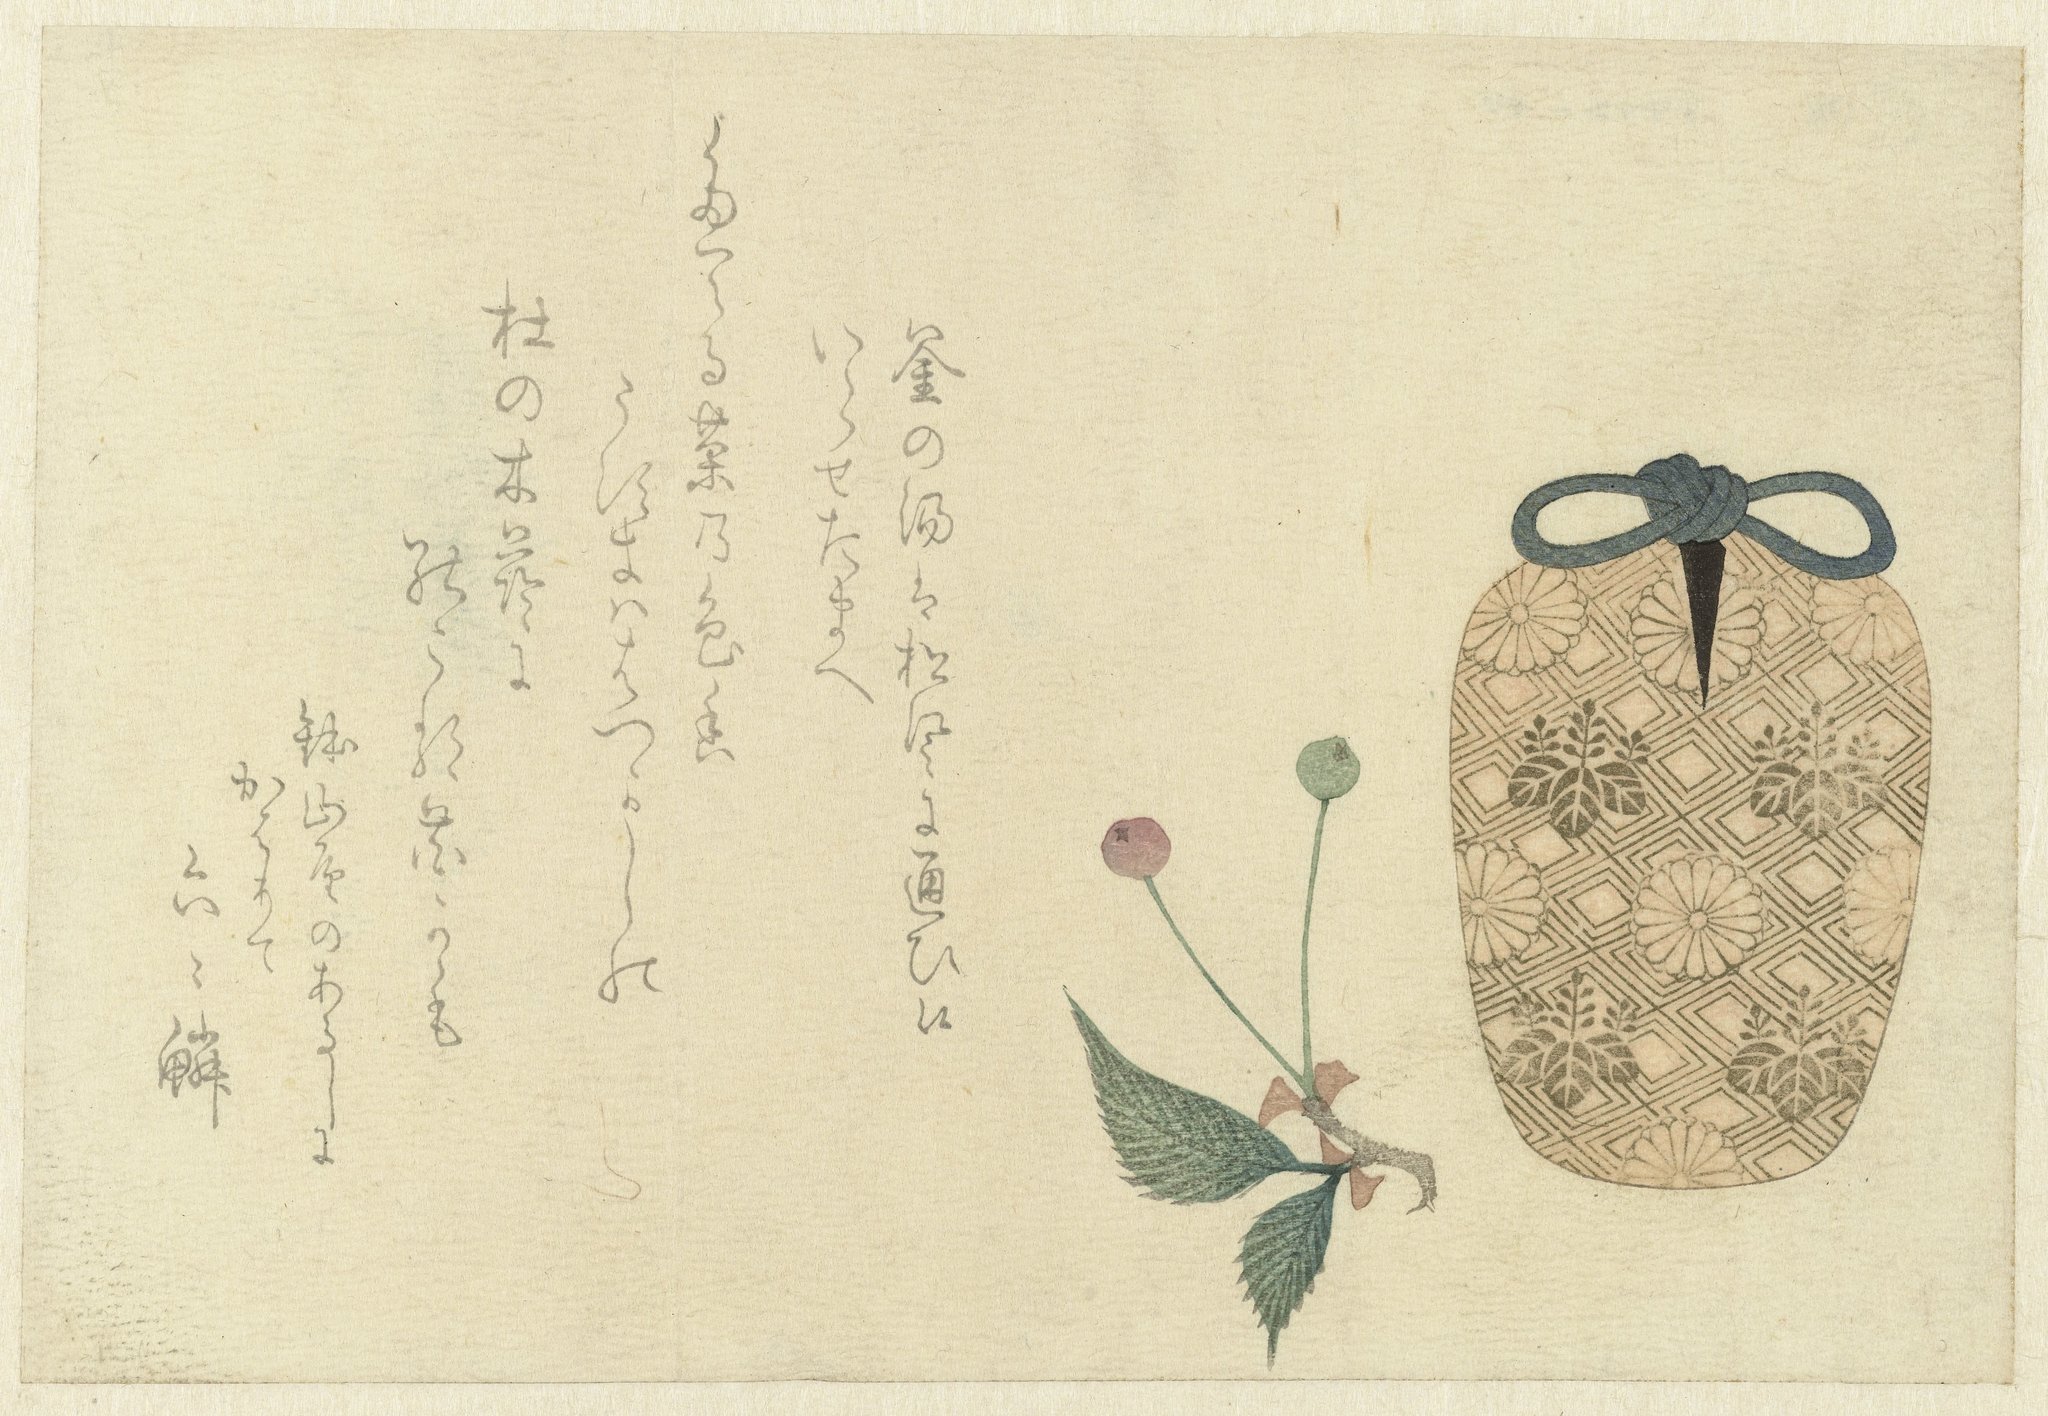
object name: print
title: Cherries and Tea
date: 1820-1830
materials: paper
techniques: woodcut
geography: japan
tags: tea-pot; samovar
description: In this surimono it is clear to see that text and image form a single entity. The various components ensure that the composition is beautifully balanced. An undulating movement starts with the tea caddy in the brocade case and flows via the twig with the two cherries to the lines of verse. Each element has its place.